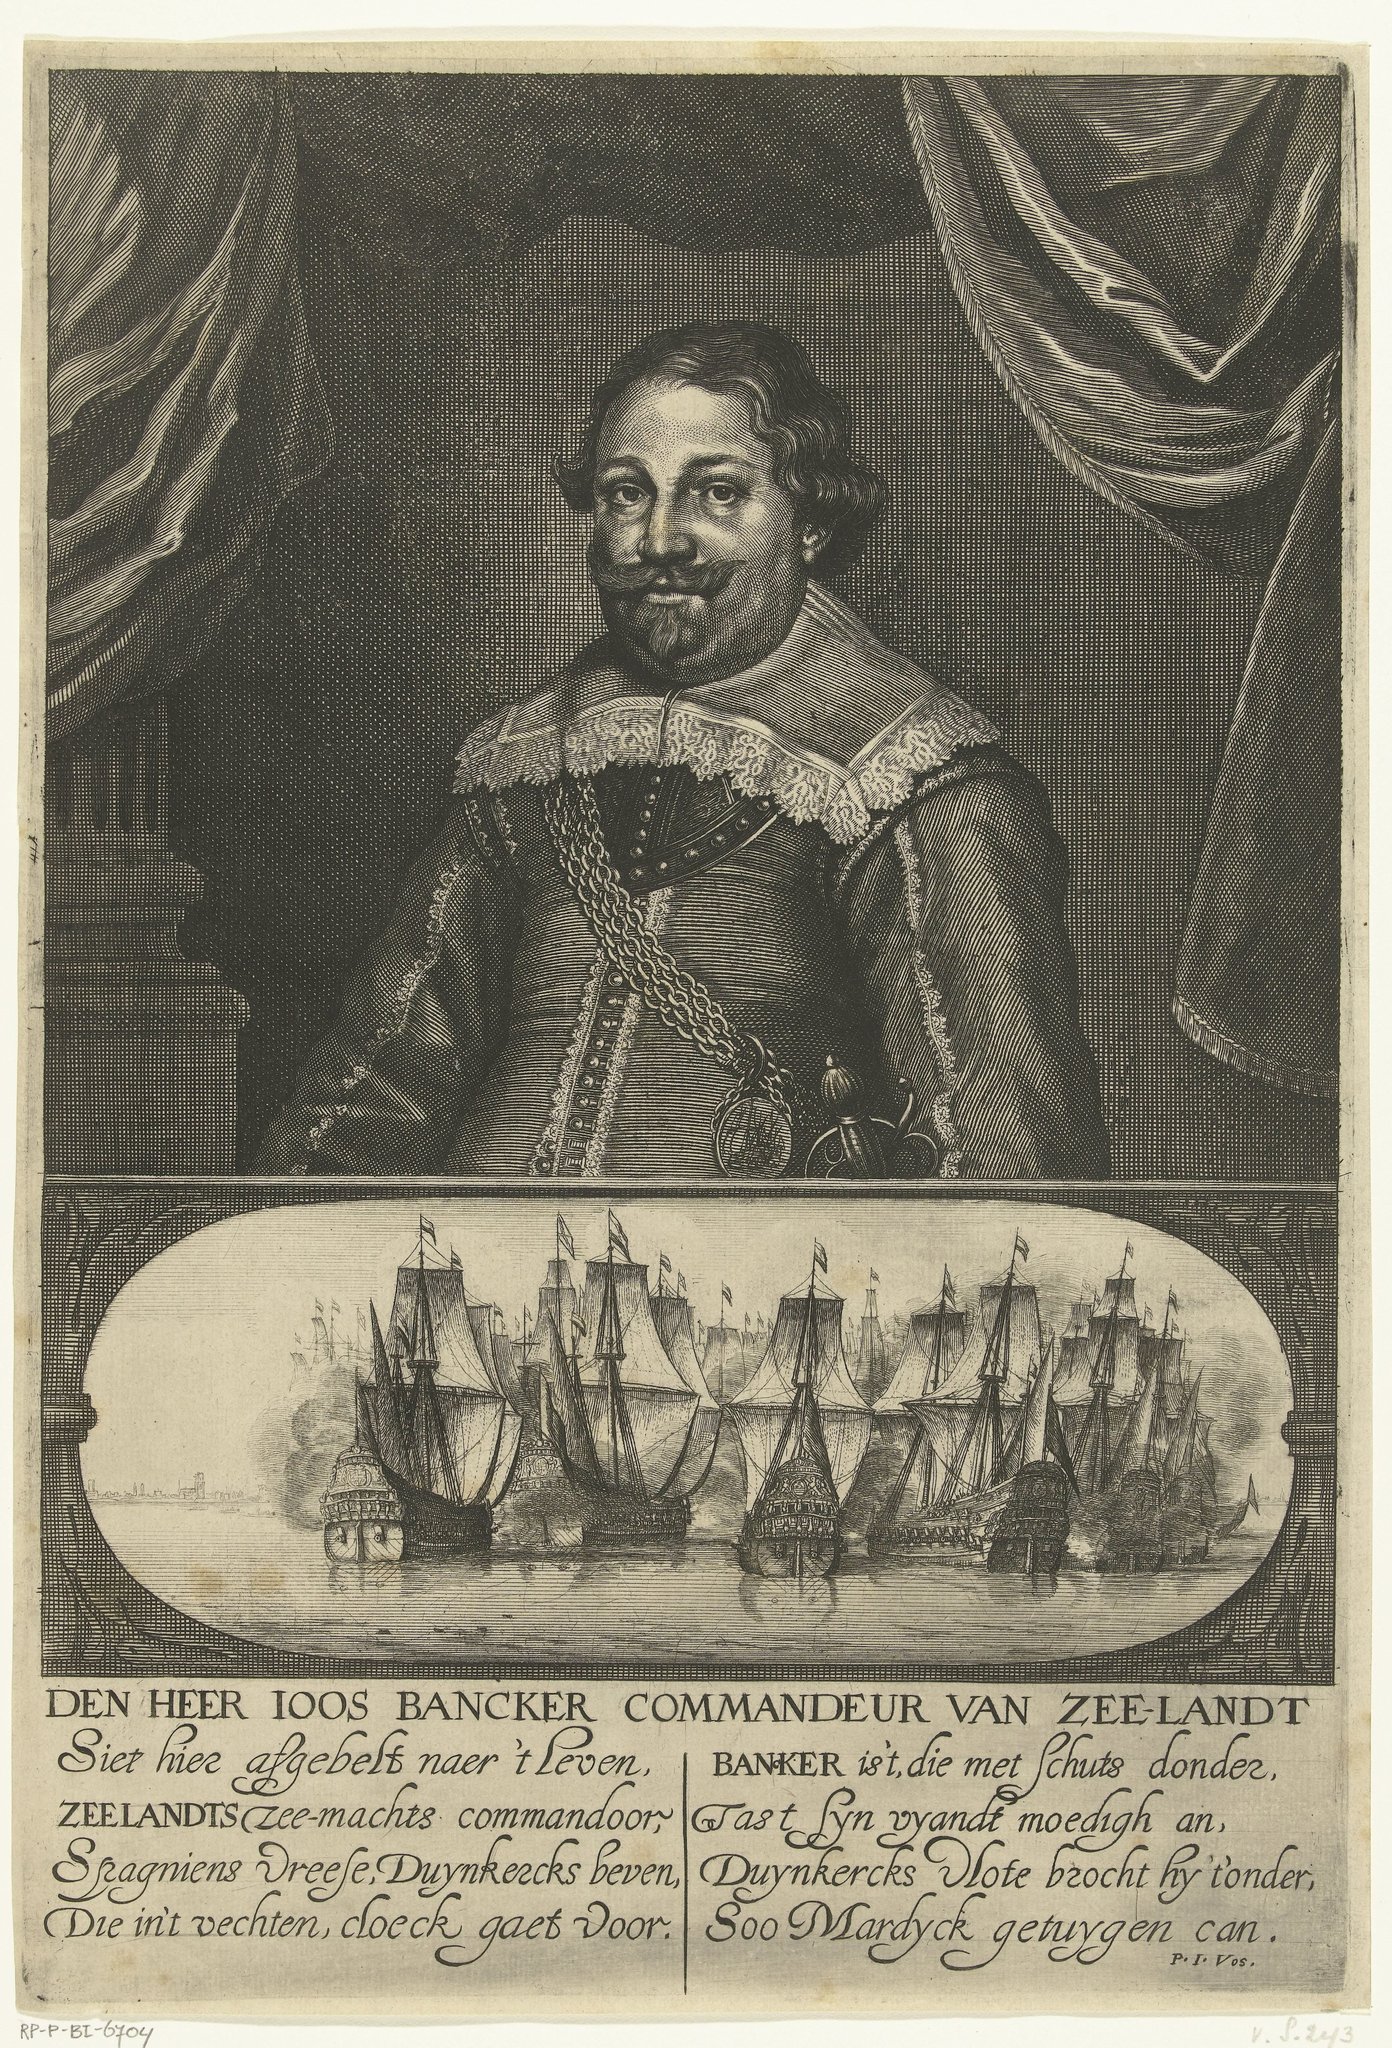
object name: print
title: Portret van Joost Banckert, vlootvoogd van Zeeland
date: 1612-1665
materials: paper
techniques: engraving, etching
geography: netherlands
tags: flushing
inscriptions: collector's mark: Lugt 2228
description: Portret van Joost Banckert, vlootvoogd van Zeeland. Onder het portret ten halven lijve is een zeeslag weergegeven, mogelijk de slag bij Duinkerken op 18 februari 1639 waar het Nederlandse vers in de marge naar verwijst.